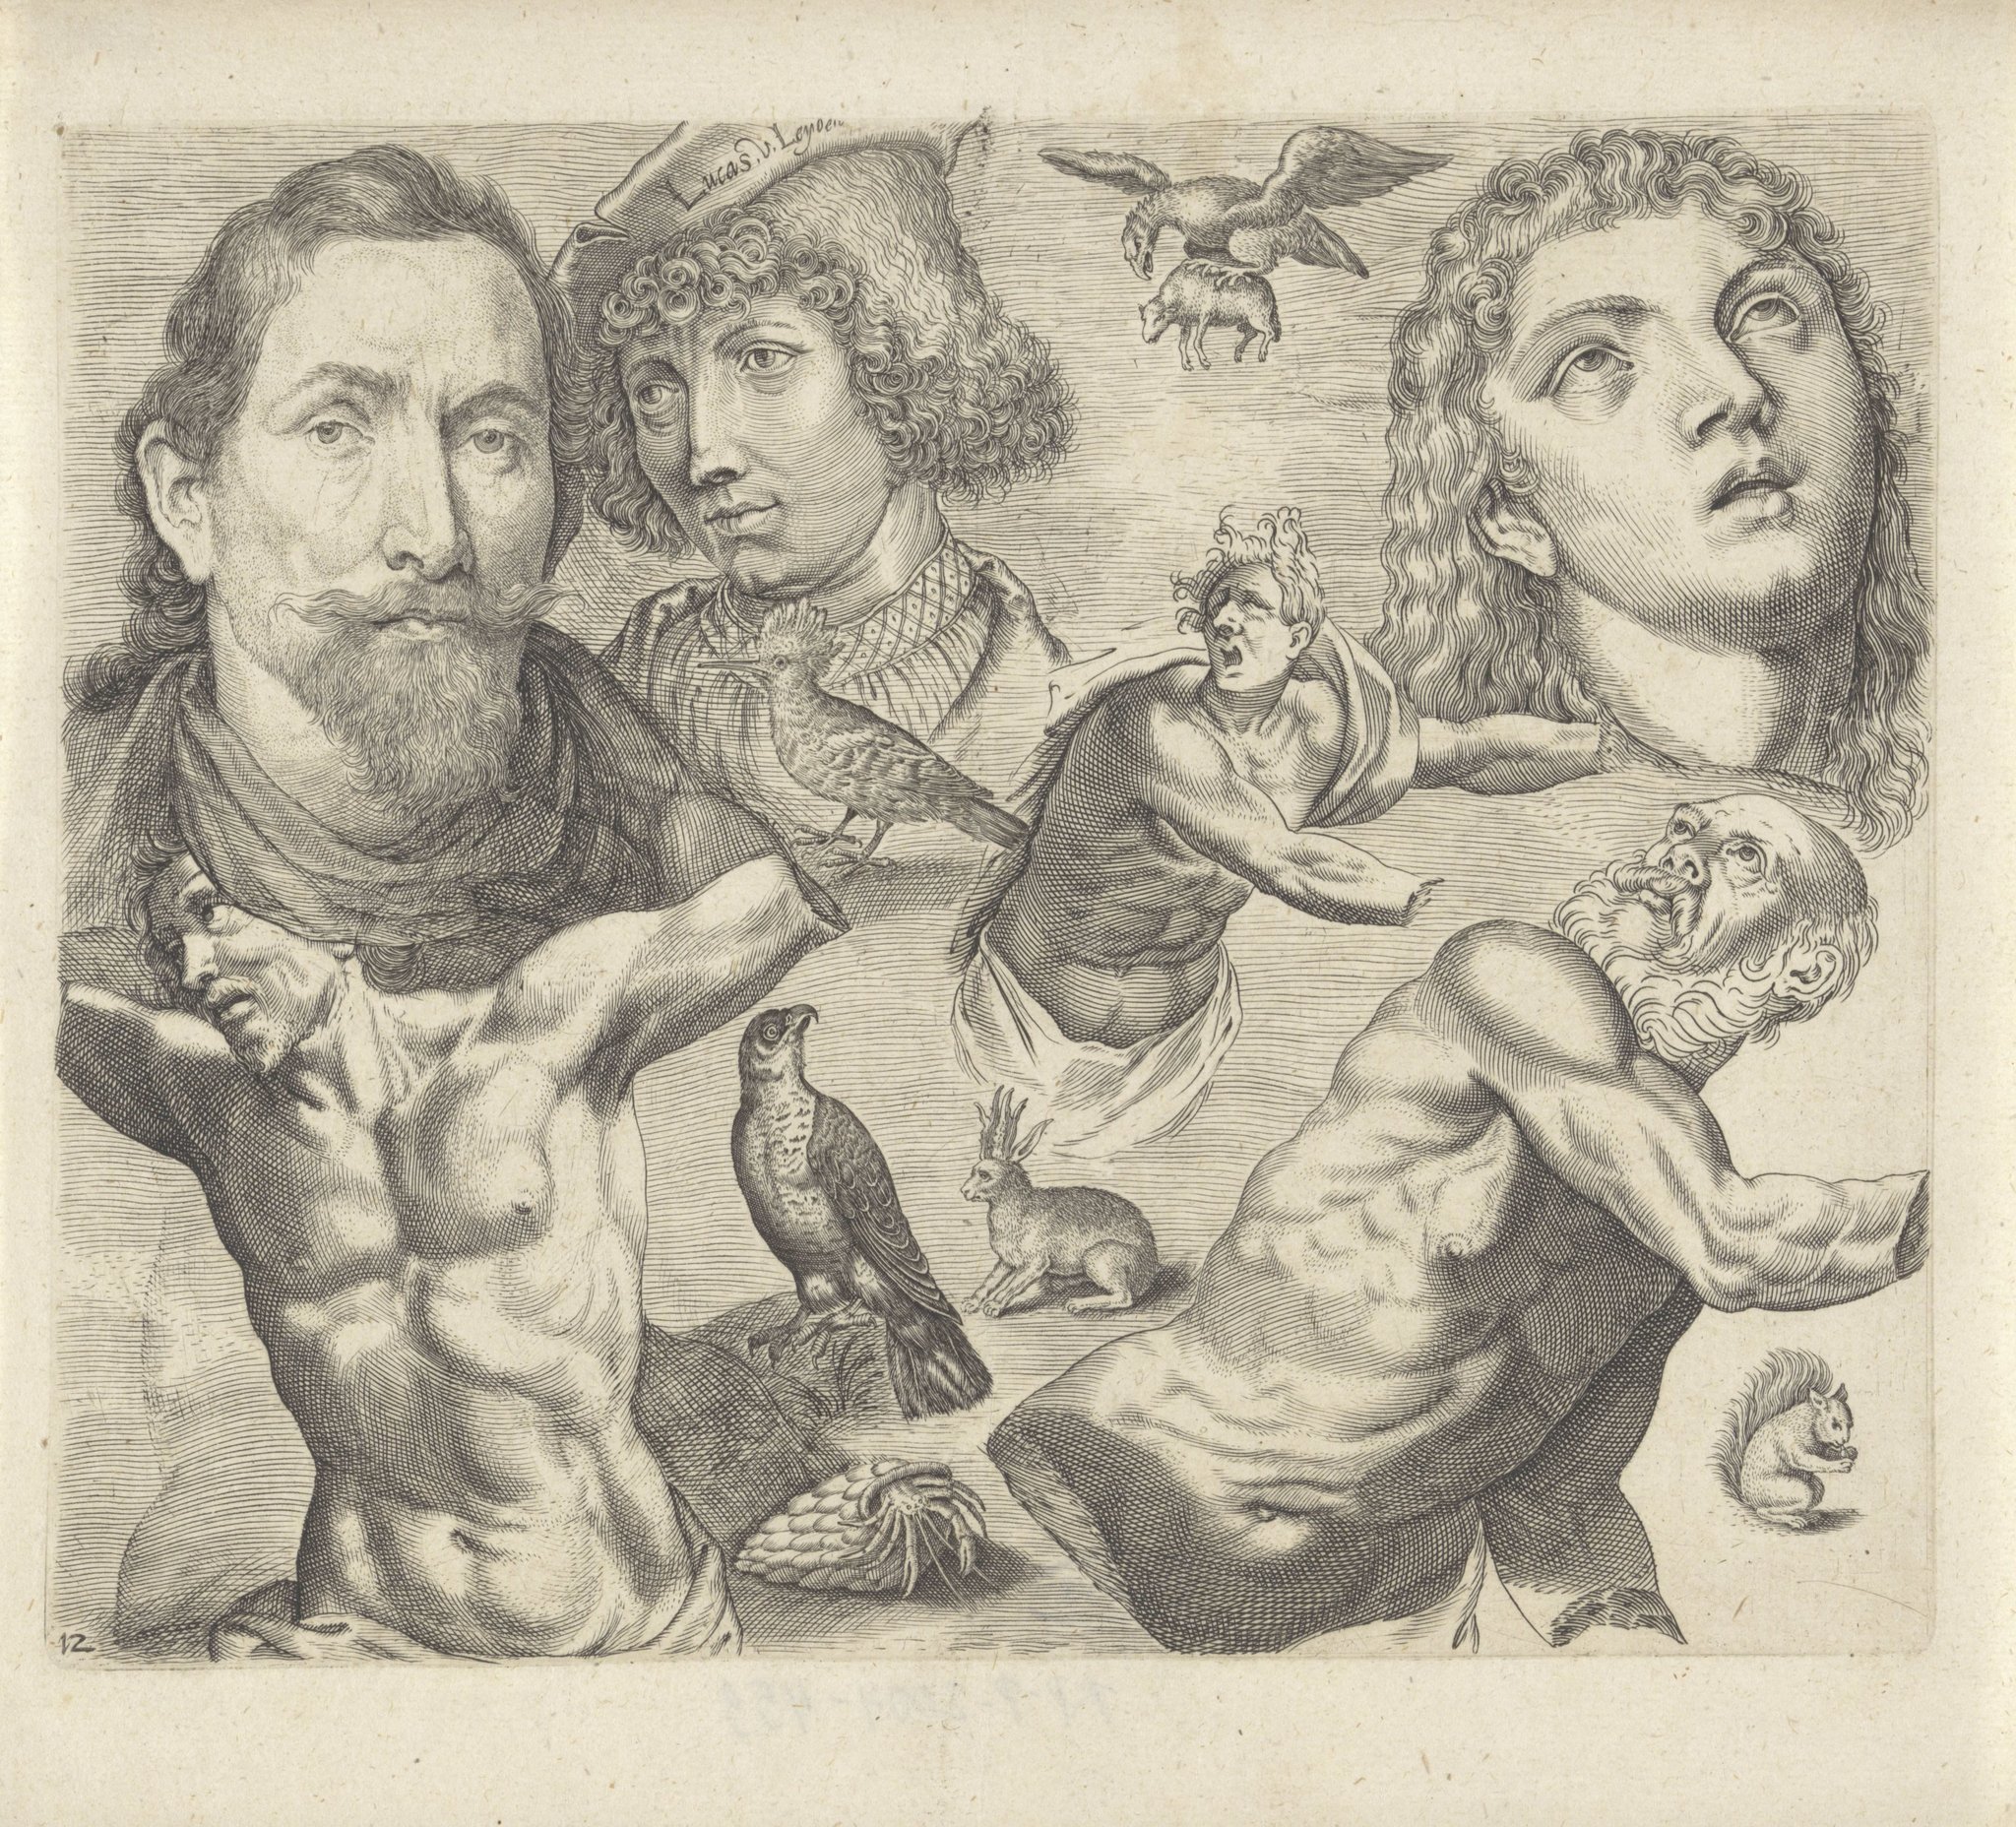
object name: print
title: Tekenvoorbeelden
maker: michael snijders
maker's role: print maker, publisher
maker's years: 1586-1672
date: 1610-1672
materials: paper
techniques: engraving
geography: antwerp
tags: head (human), chest, bust, rodents: hare - ff - fabulous animals (sometimes wrongly called 'grotesques'); 'mostri' (ripa), other birds: hoopoe, flight, running away; pursuing, predatory birds, sheep, crustaceans: lobster, rodents: squirrel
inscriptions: number: ‘12’, collector's mark: Lugt 2228, collector's mark: Lugt 2760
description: Twaalfde prent uit een serie tekenvoorbeelden van onbekende omvang. Studieblad met linksboven een portret van Lucas van Leyden, naast een tweede portret van een man. Linksonder torso. Rechtsboven kop Maria Magdalena. Midden en links twee studies van wegvluchtende mannen. Daaromheen dieren: een vliegende adelaar met schaap in de poten, een hop, een eekhoorn, een uit een schelp kruipende heremietkreeft, een haas met horens, een roofvogel en een eekhoorn.